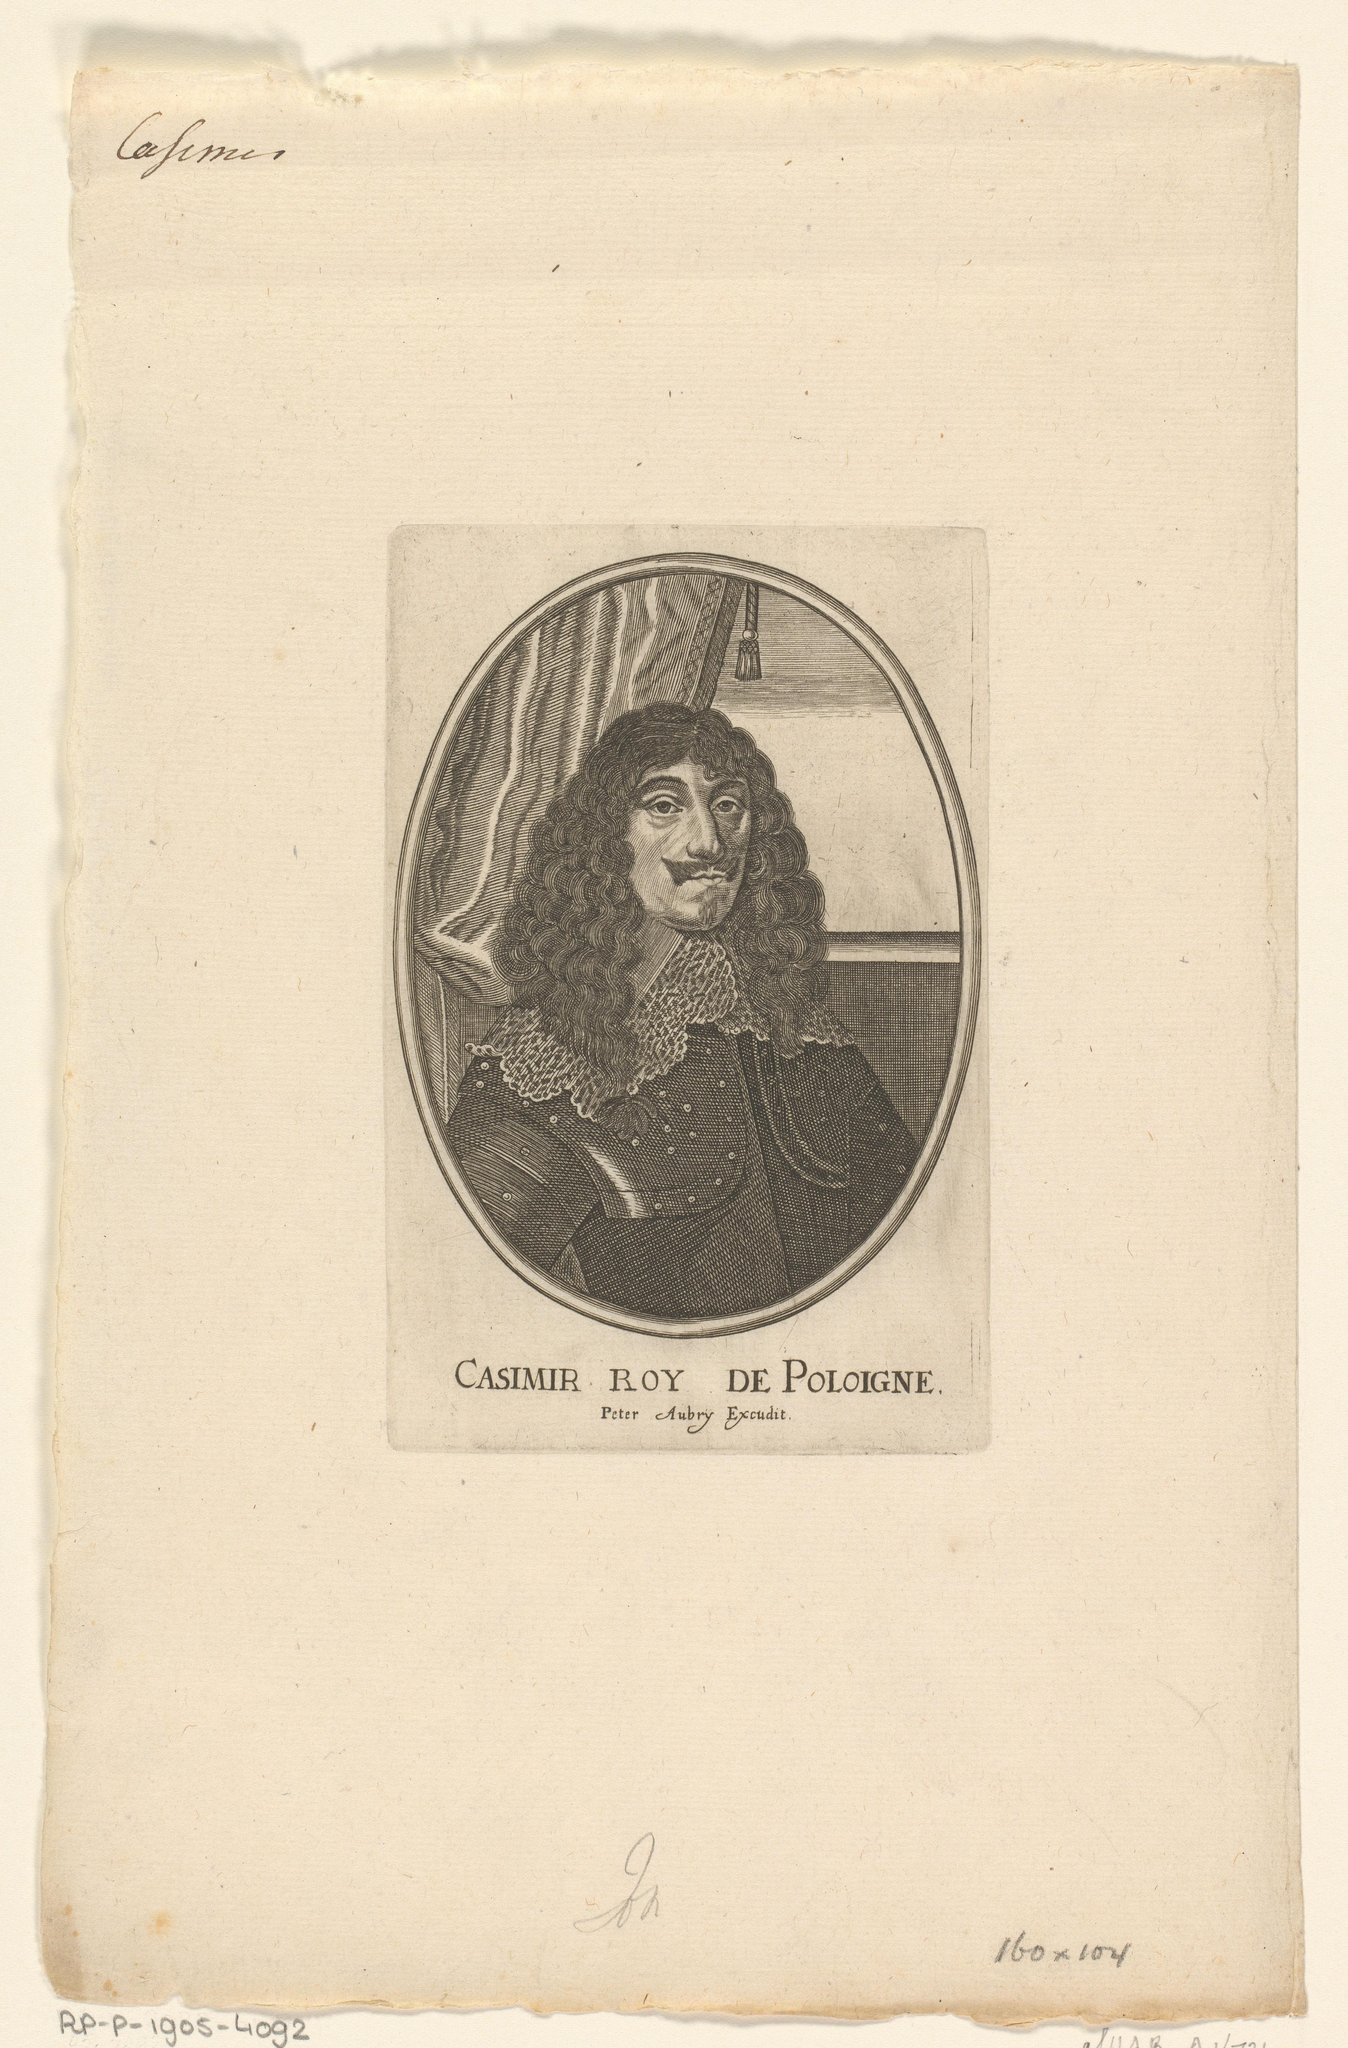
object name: print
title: Portret van Jan II Casimir van Polen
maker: Anonymous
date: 1648-1686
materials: paper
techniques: engraving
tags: historical persons, ruler, sovereign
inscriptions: inscription: ‘Casimir’, collector's mark: Lugt 2228